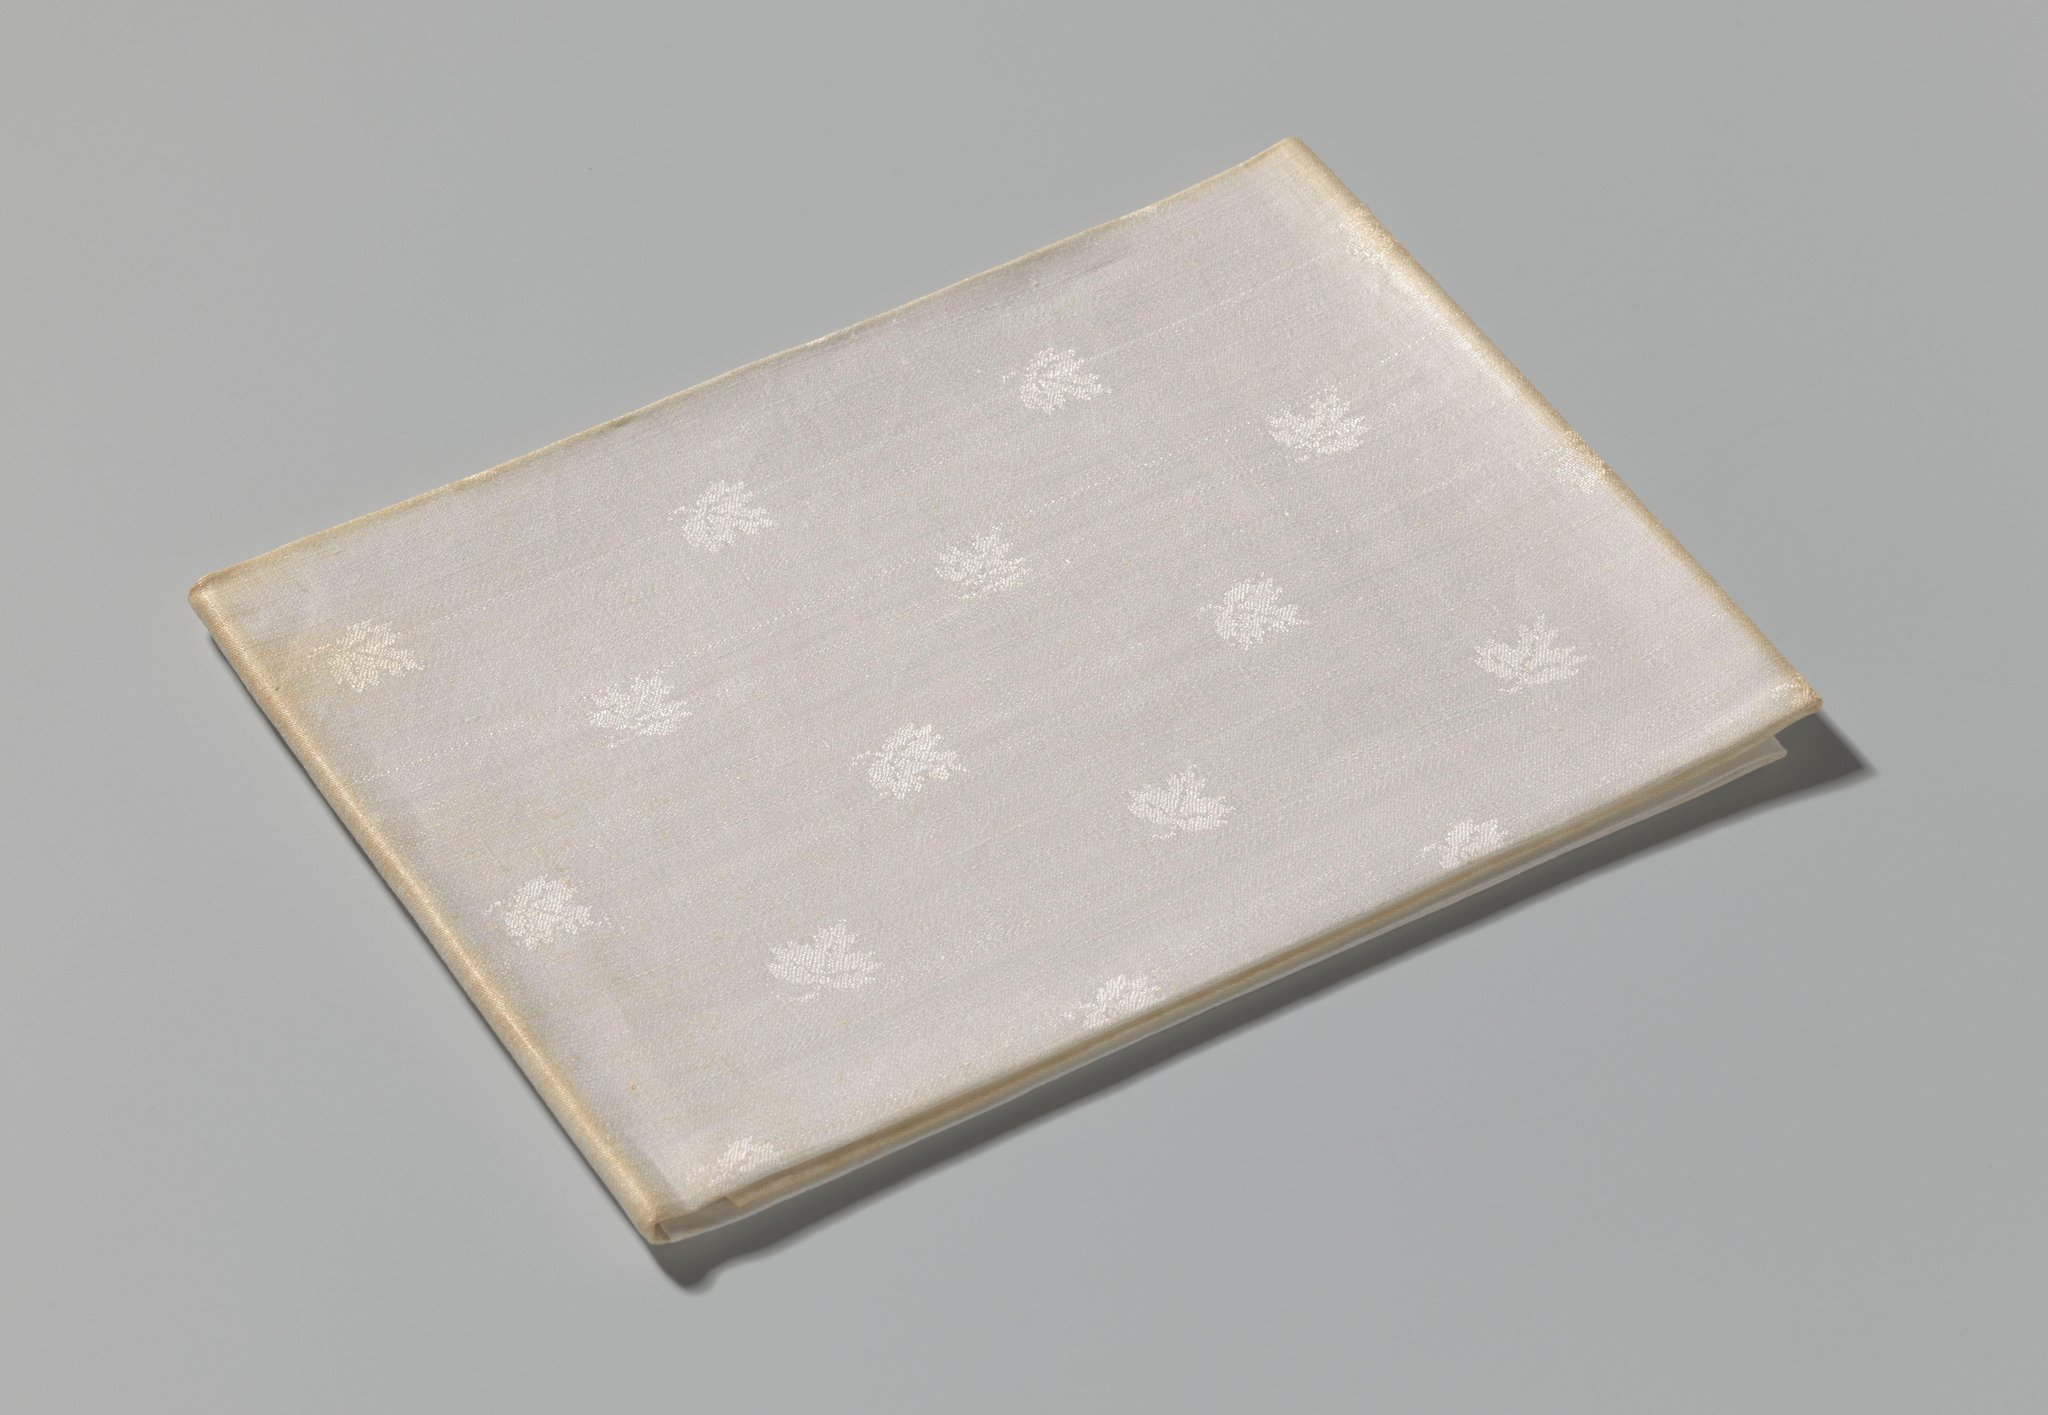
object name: napkin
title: Servet met strooimotief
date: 1800-1900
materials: linen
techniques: damask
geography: netherlands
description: Servet van wit linnendamast met strooimotief; oorspronkelijk een buffetloper, tot twee servetten vermaakt.